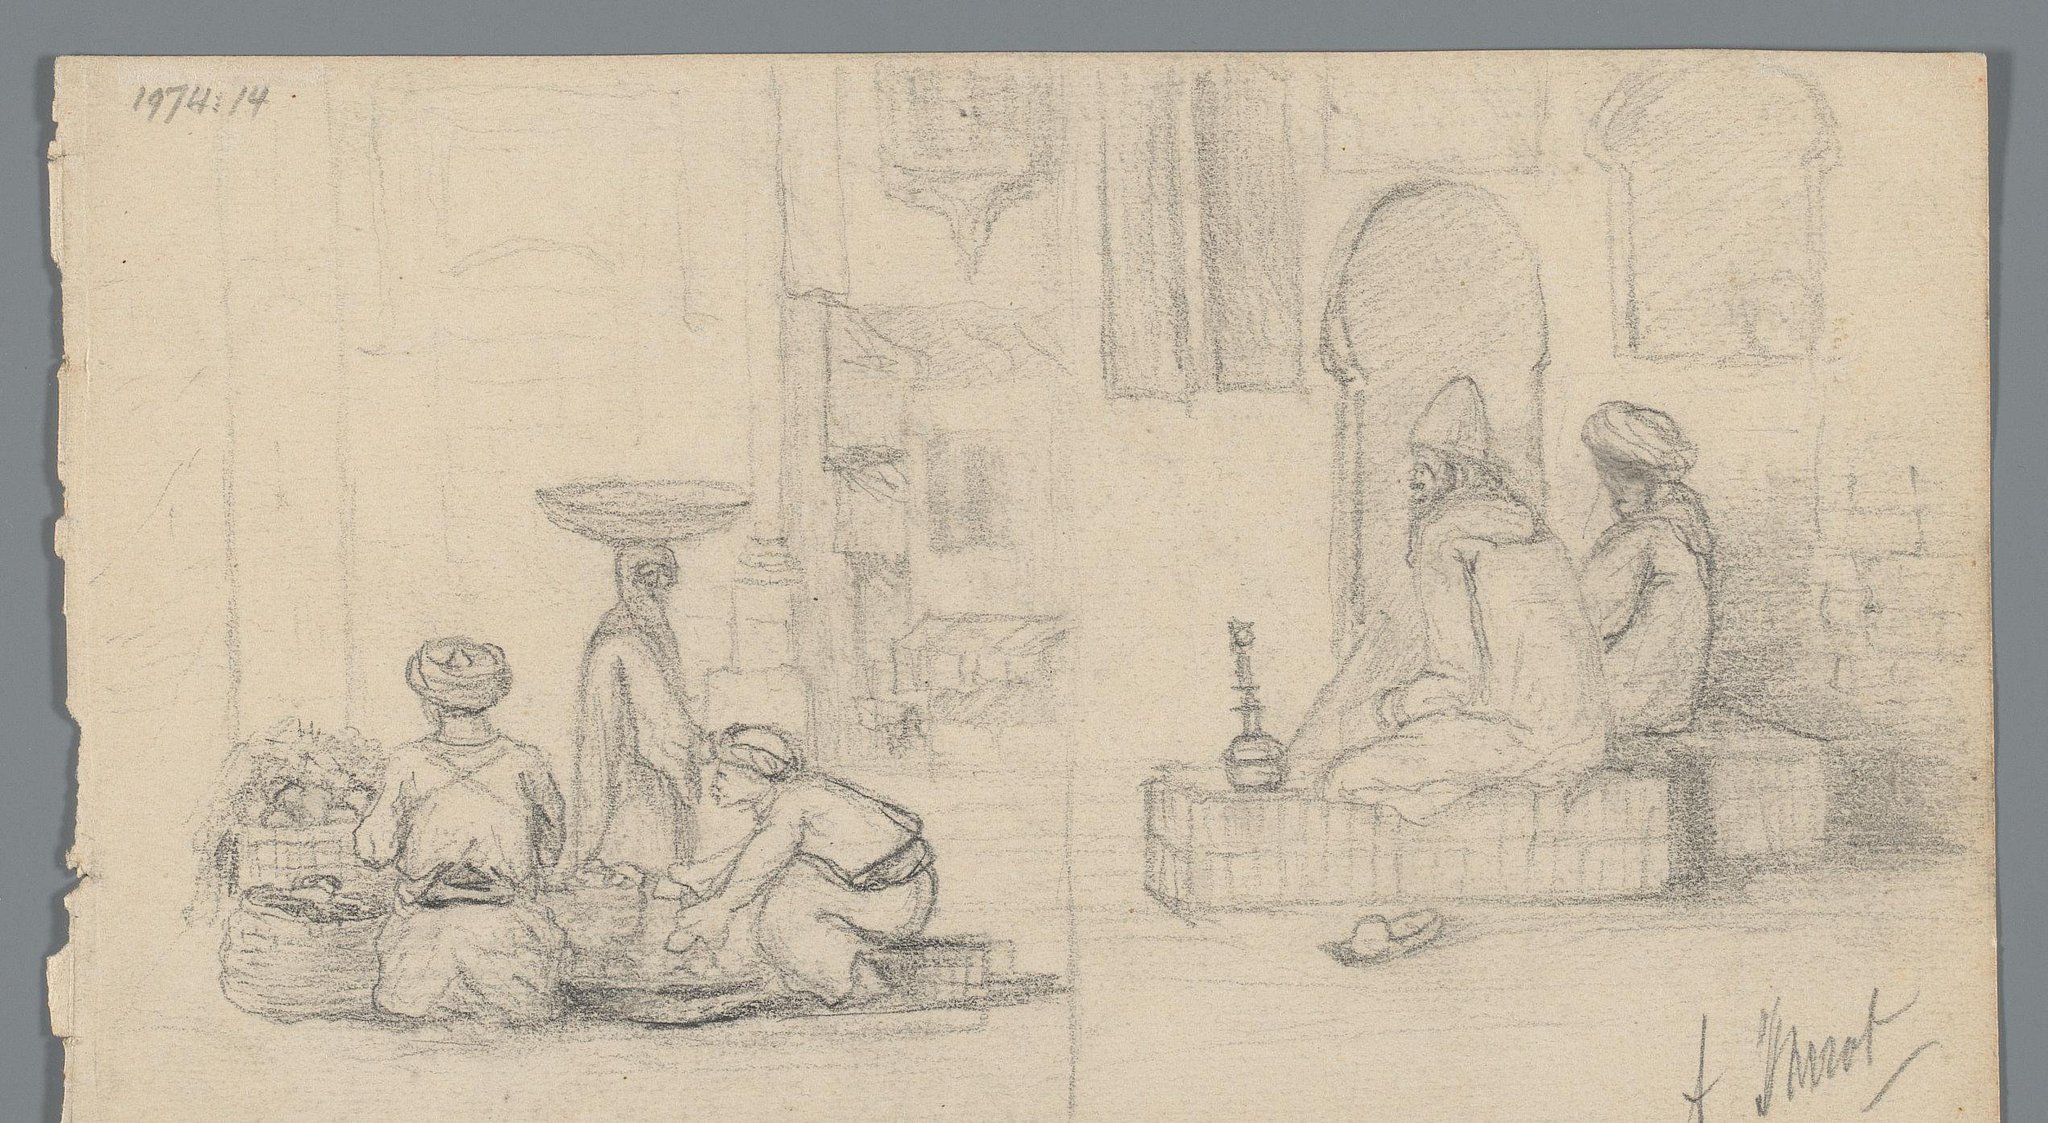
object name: sketchbook leaf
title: Egyptische reis van 1858-1859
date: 1858-1859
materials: paper, pencil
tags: communal rooms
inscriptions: signature: ‘A [...]ot’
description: Onderdeel van 20 losse bladen met tekeningen gemaakt tijdens Famars Testas zijn Egyptische reis van 1858, met voornamelijk figuren en dorpsgezichten met notities.